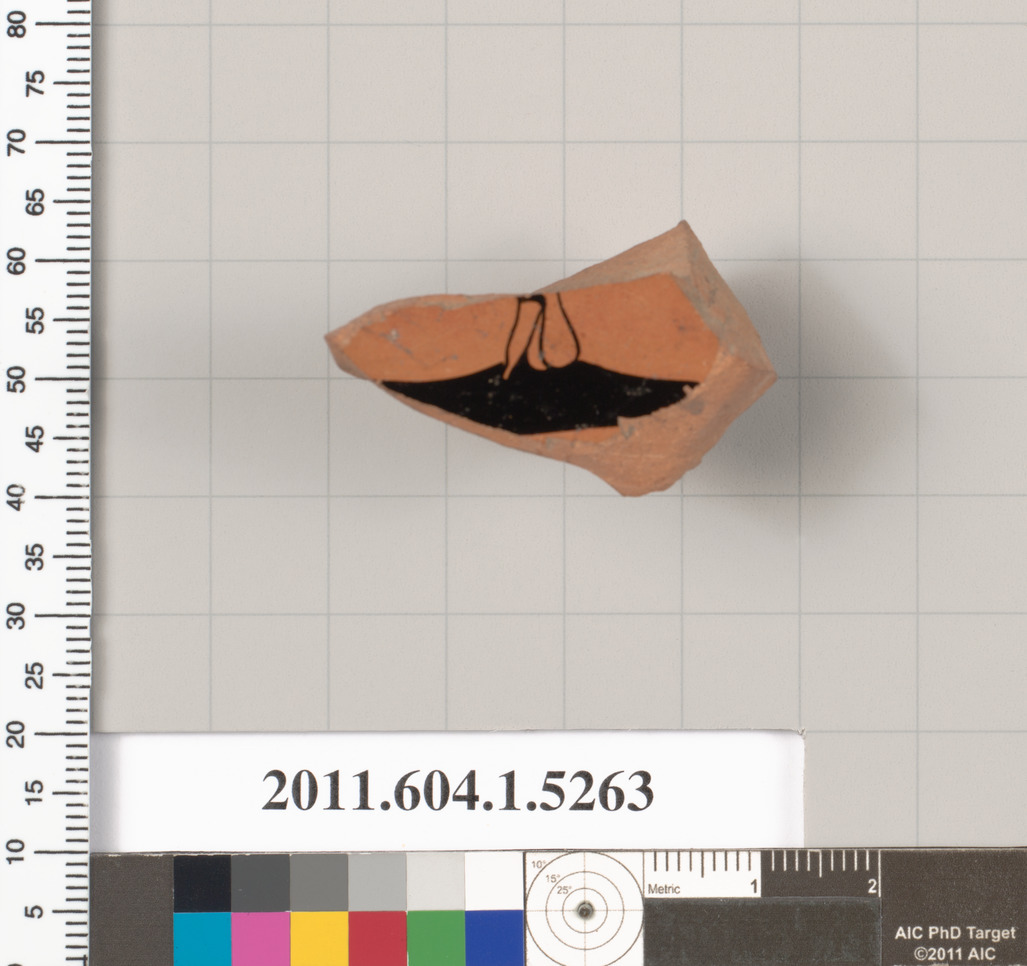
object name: kylix fragment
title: Terracotta fragment of a kylix (drinking cup)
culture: greek, attic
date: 510-490 BCE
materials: terracotta